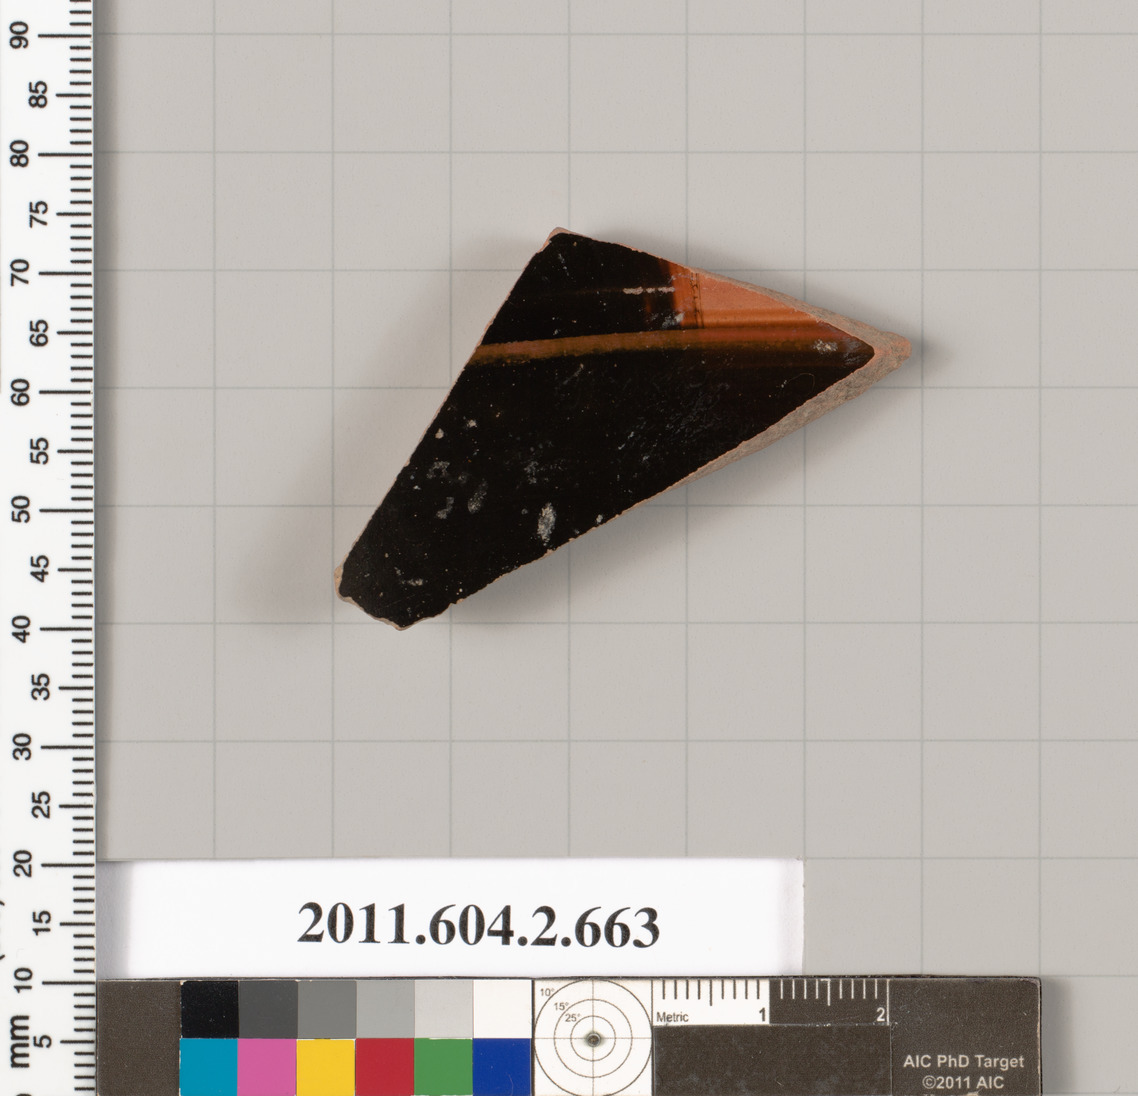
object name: column krater fragment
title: Terracotta fragment of a column-krater (bowl for mixing wine and water)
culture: greek, attic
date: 460-440 BCE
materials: terracotta